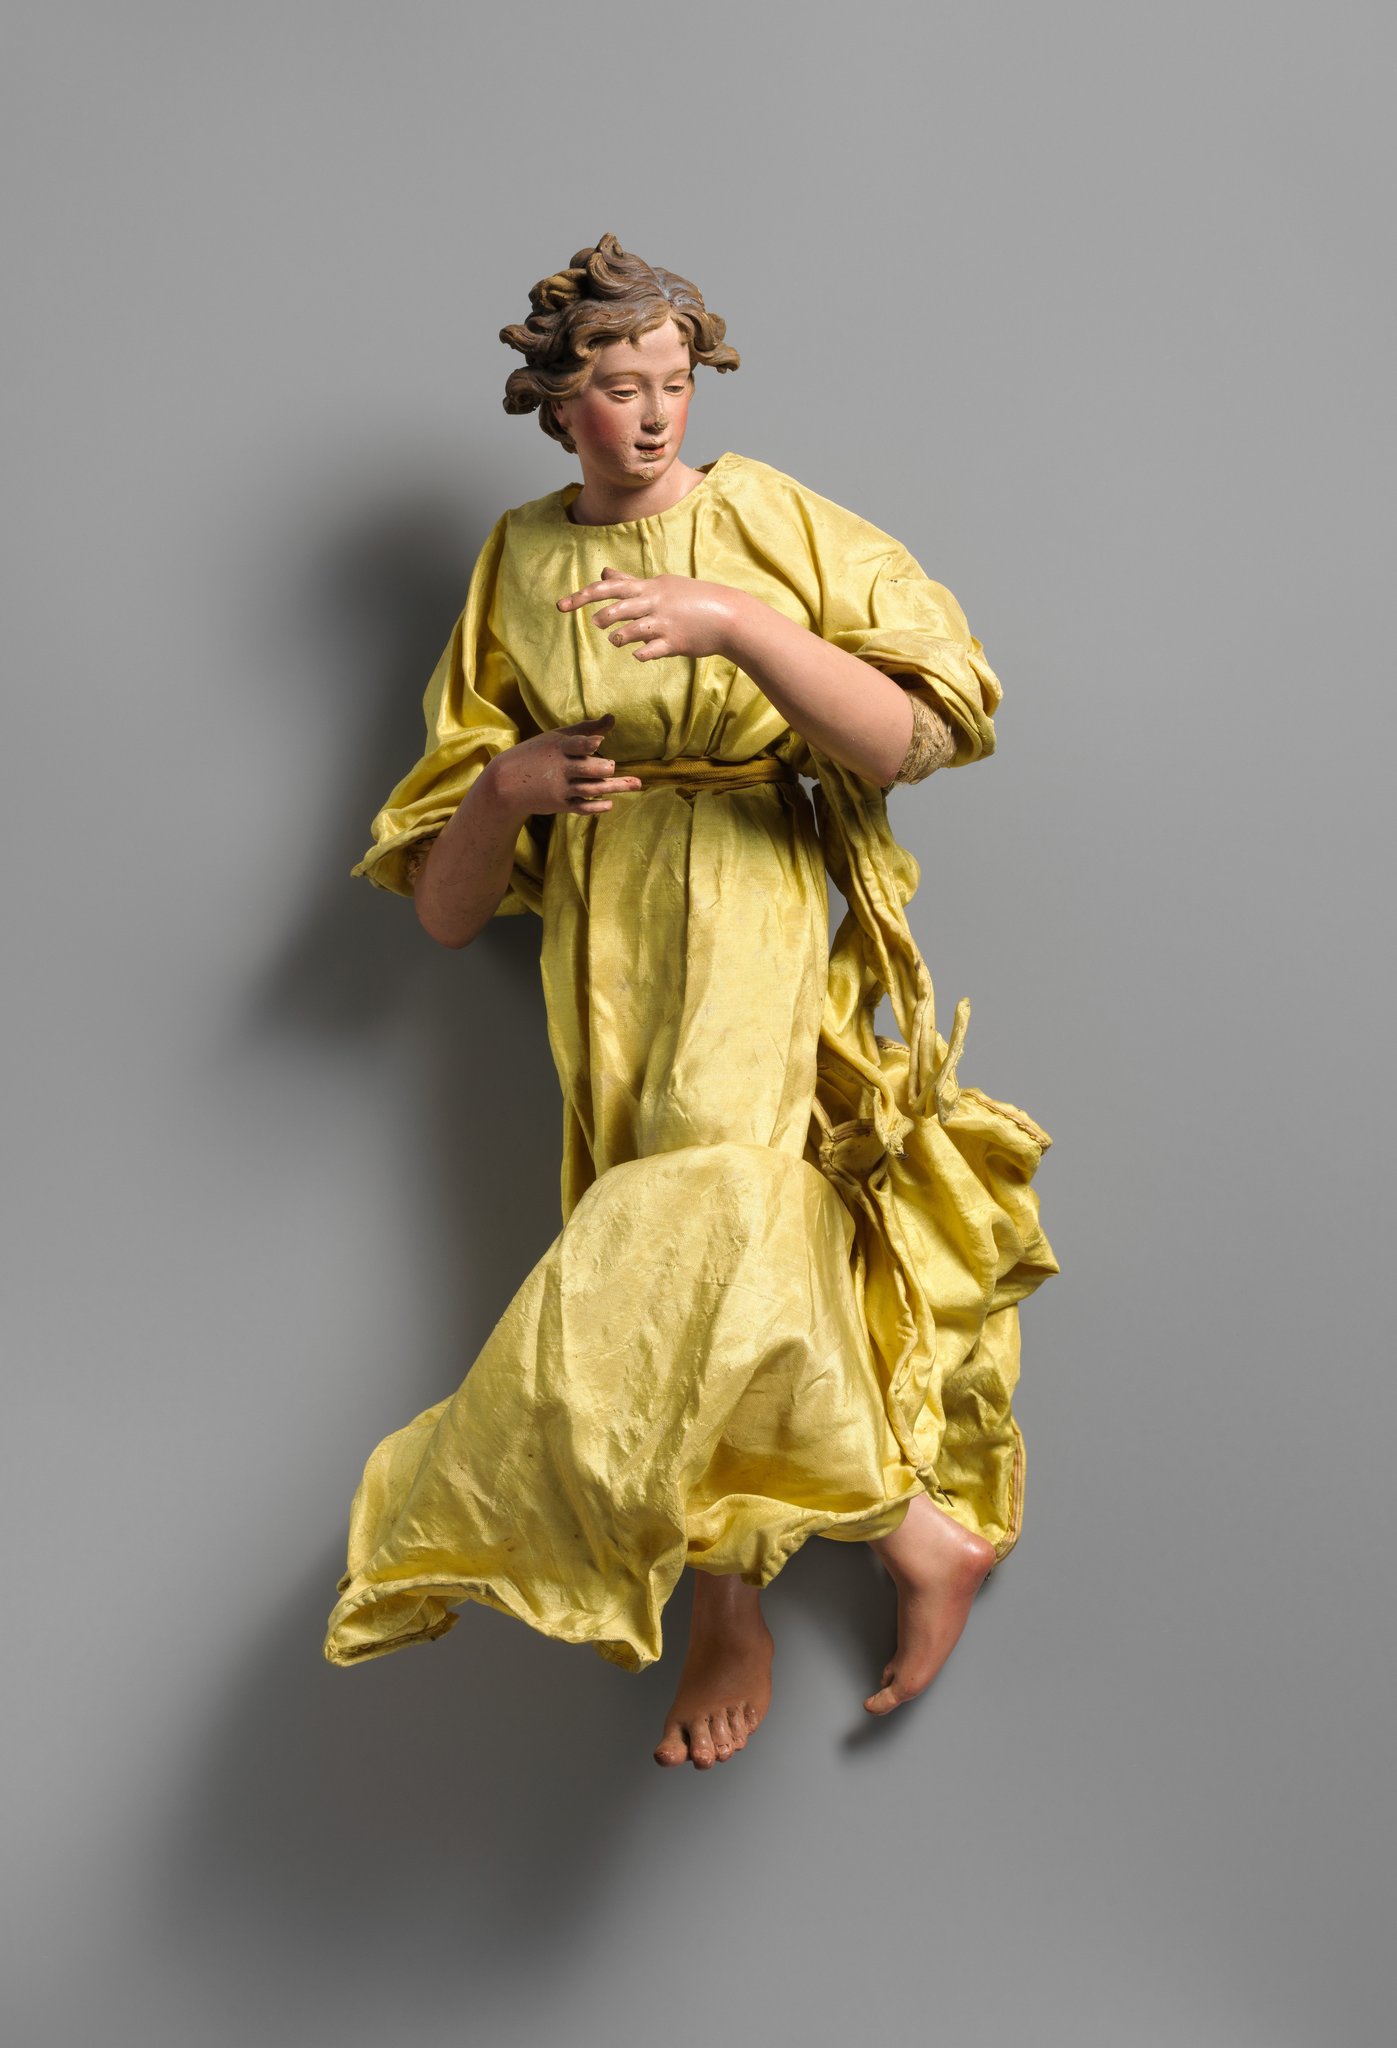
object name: crèche figure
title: Angel with yellow dress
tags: angels